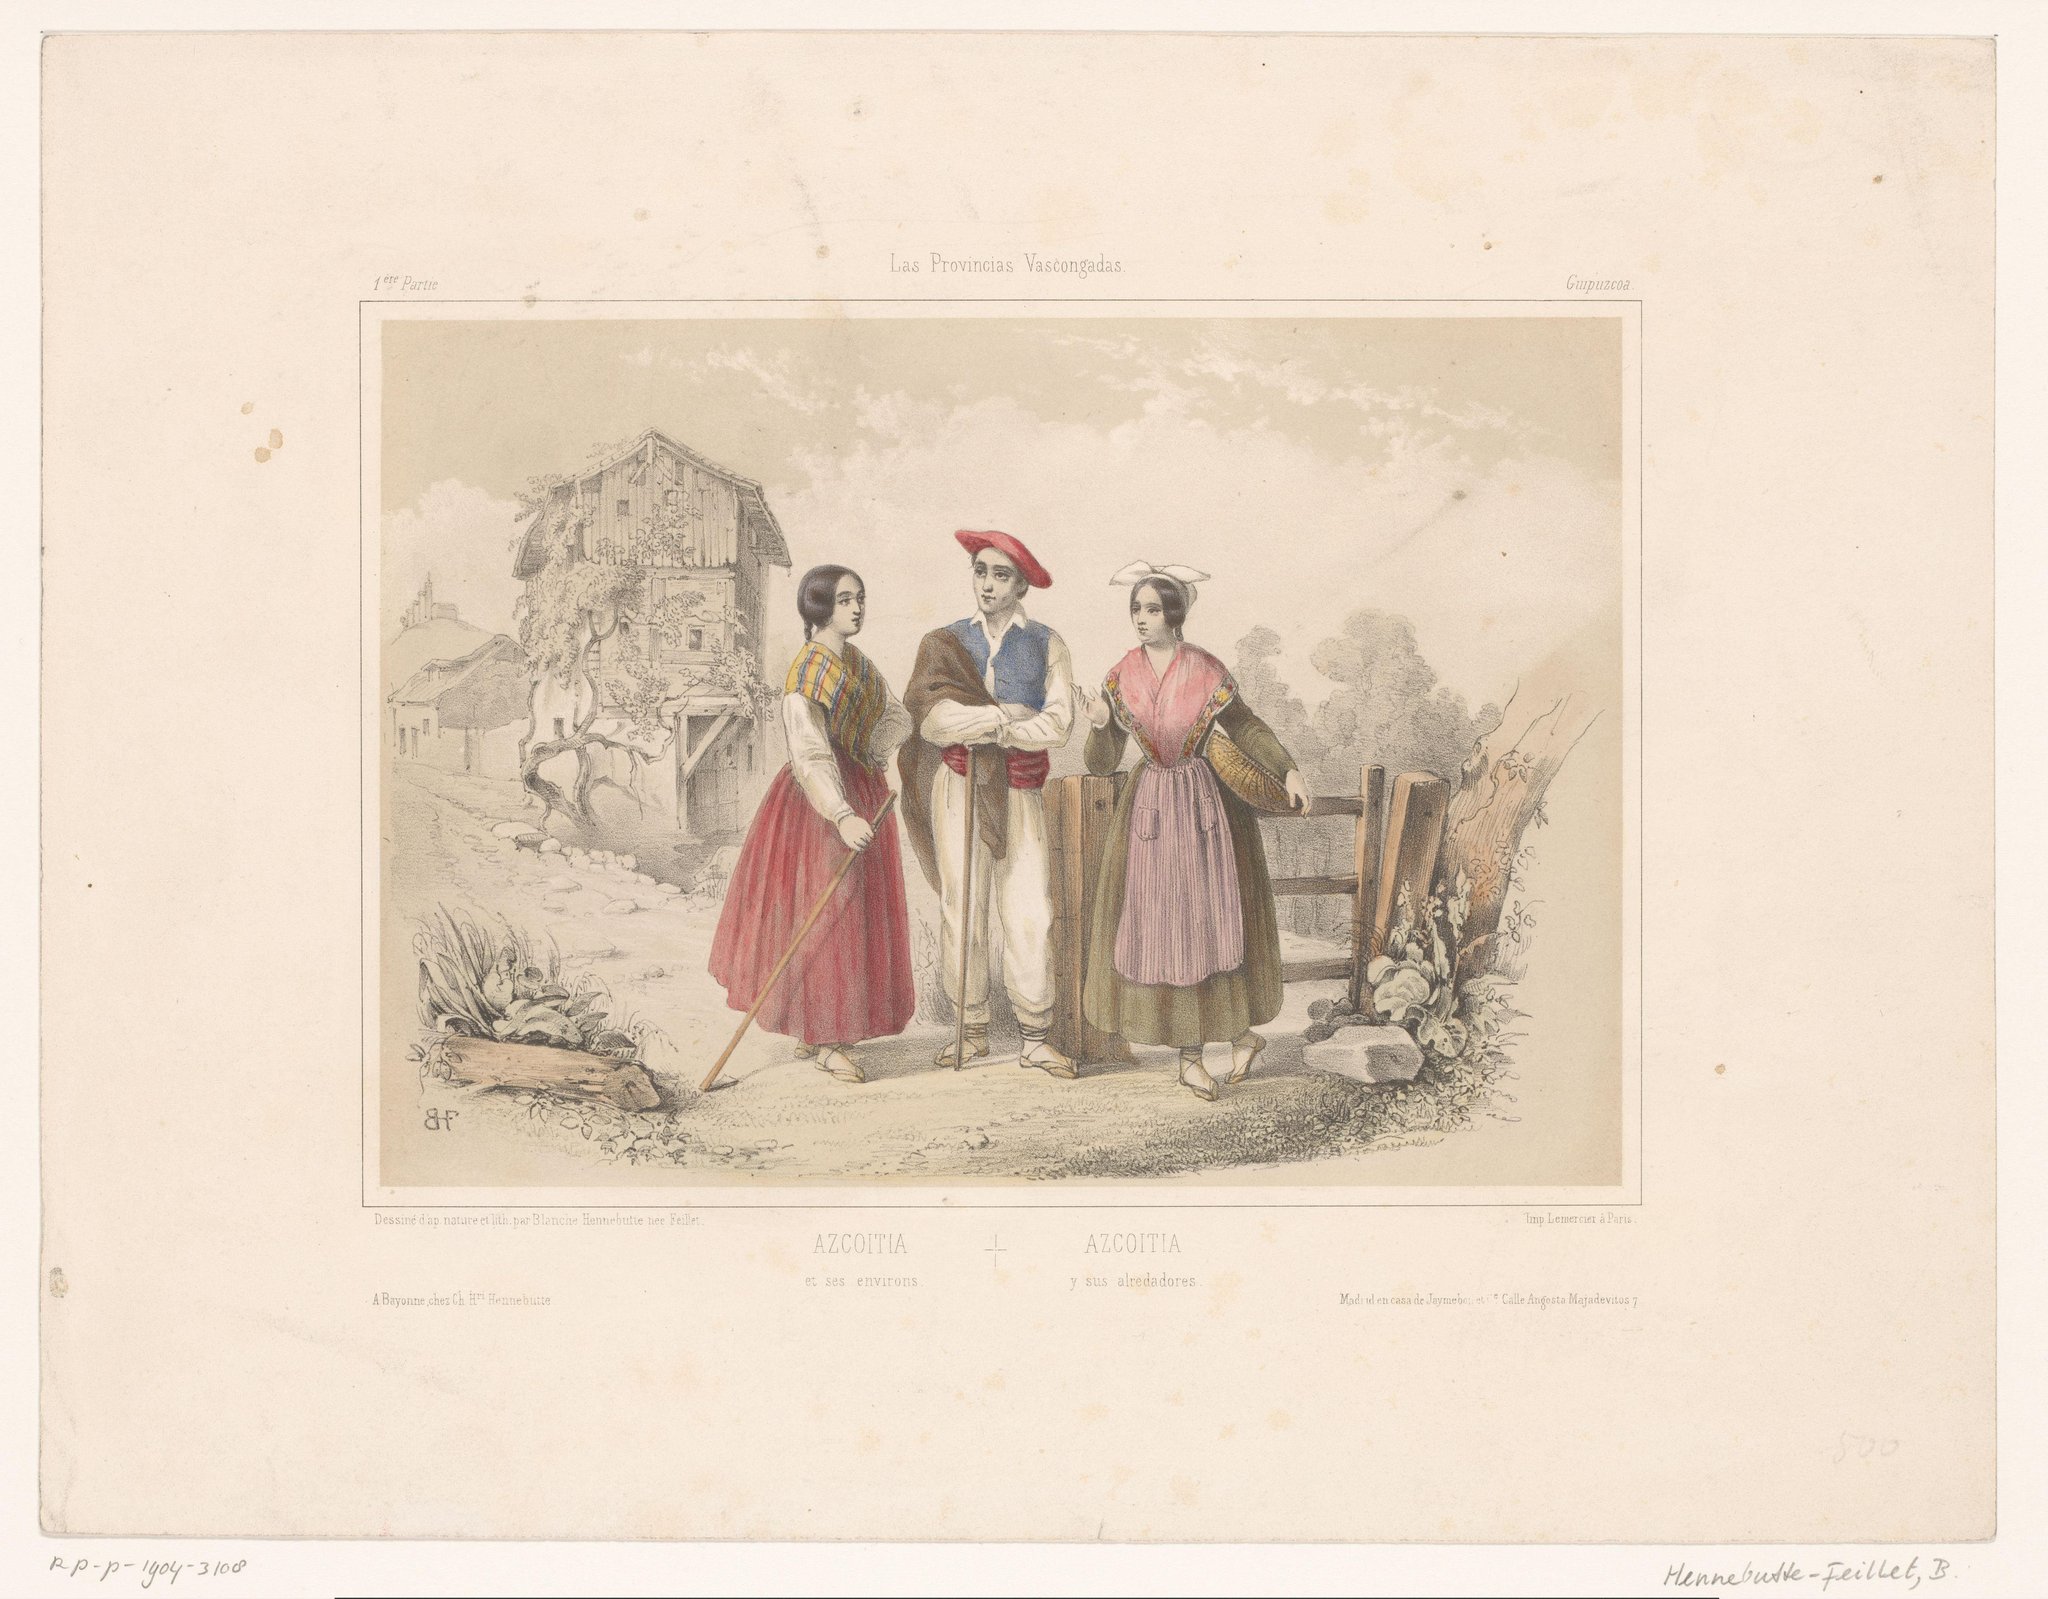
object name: print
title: Baskenland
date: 1849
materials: paper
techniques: hand coloring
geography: paris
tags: folk costume, regional costume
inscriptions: collector's mark: Briquet 2228a